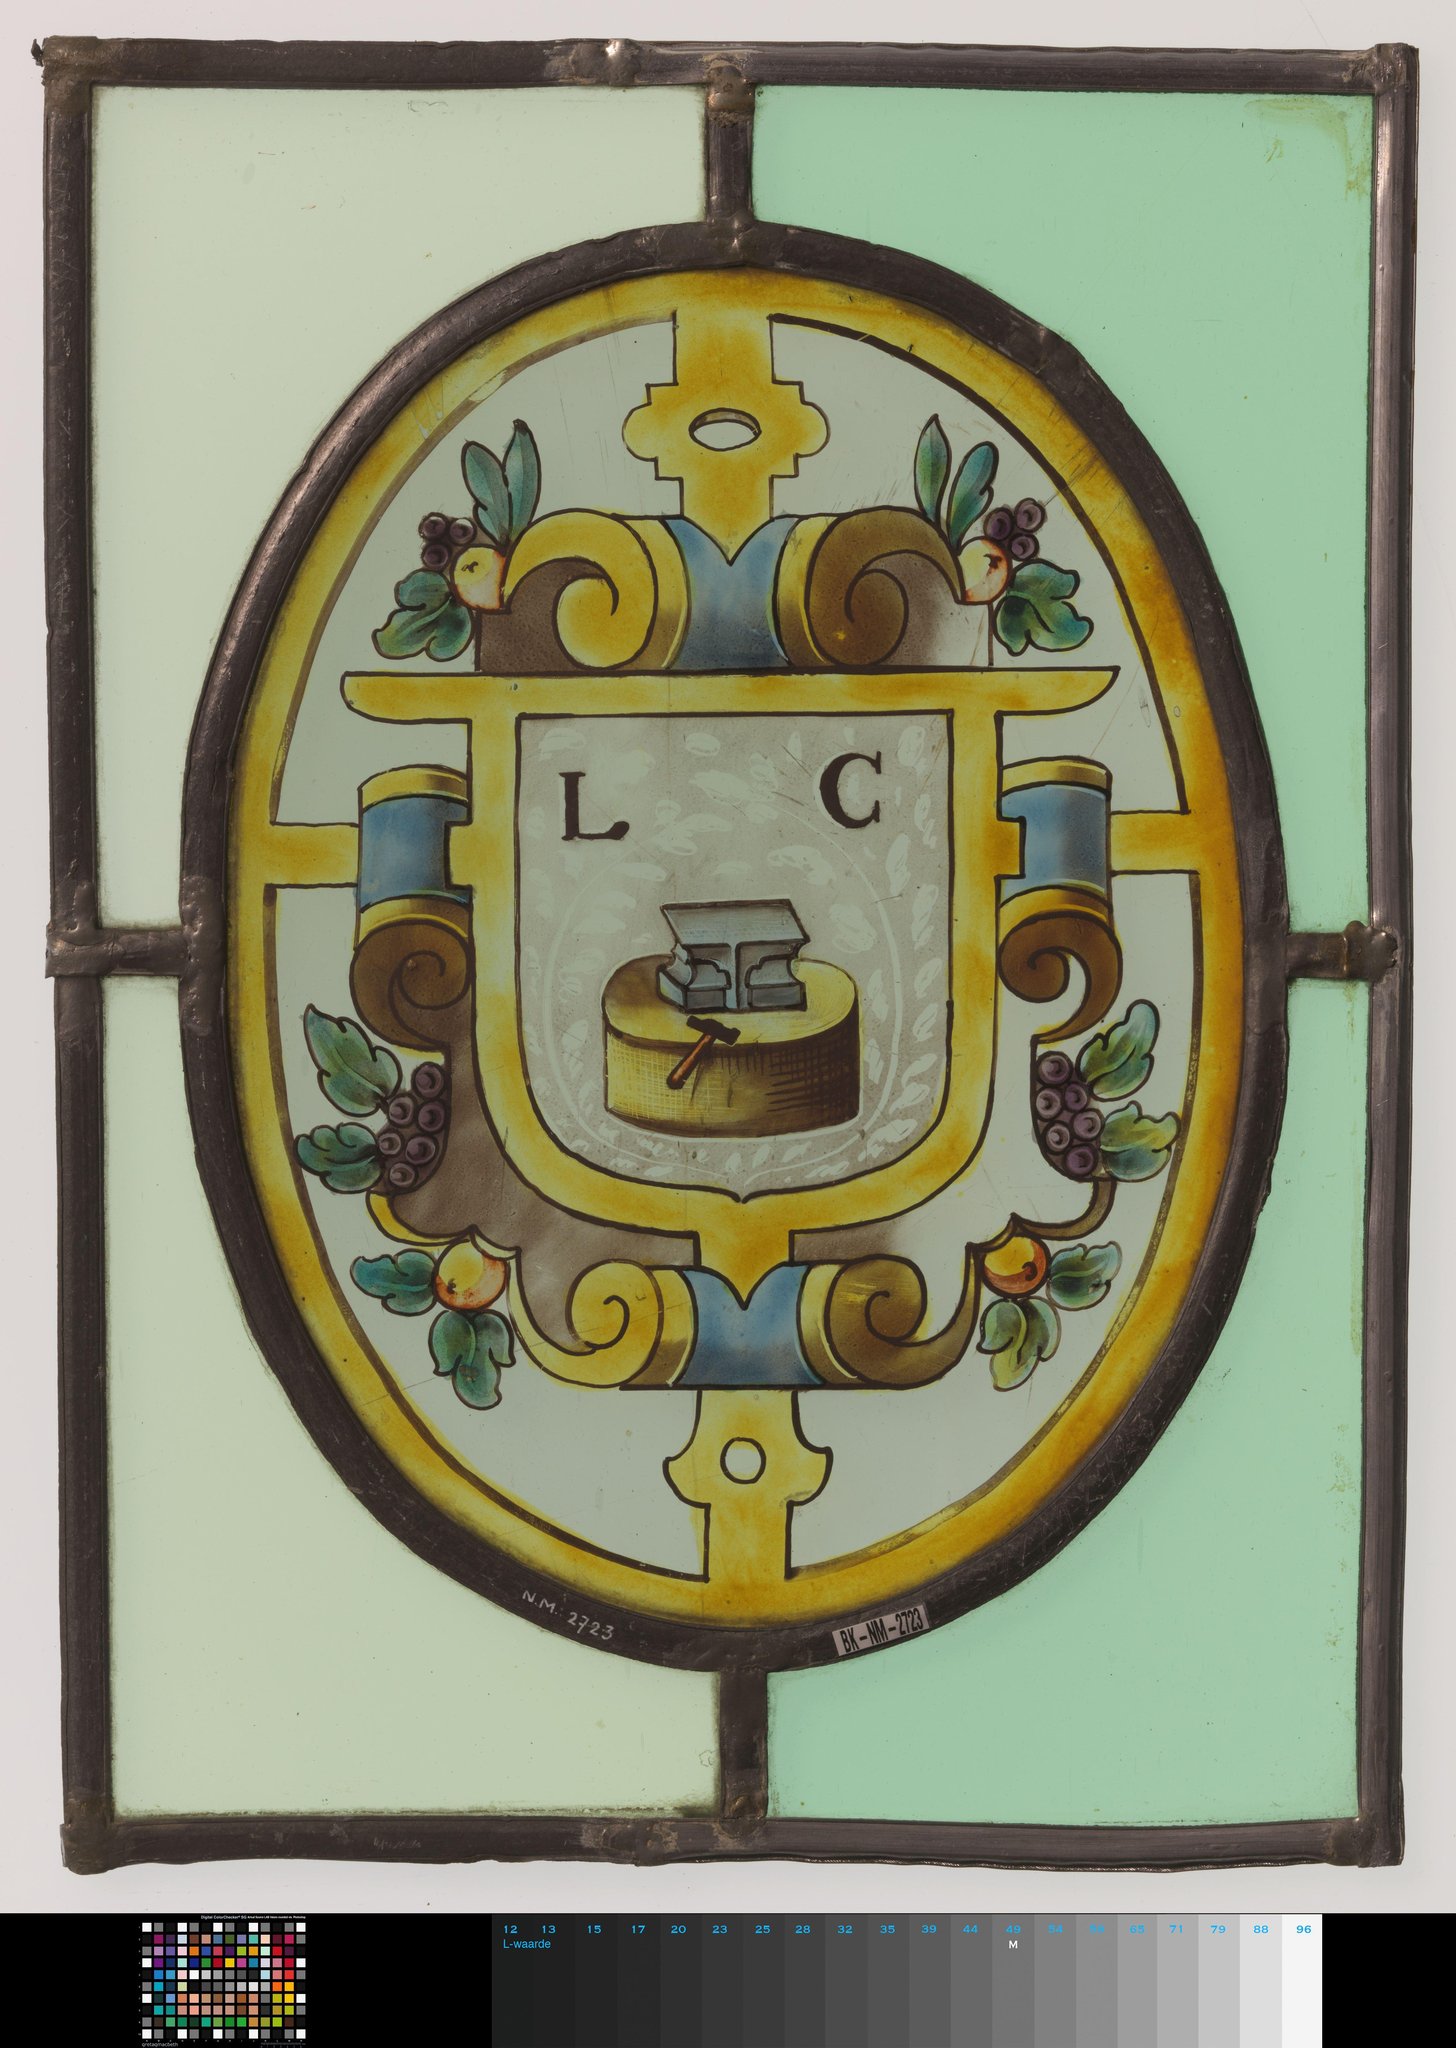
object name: wapenruit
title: Ruit waarin de letters L en C en een aambeeld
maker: Anonymous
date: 1700-1800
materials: glass, lead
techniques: leading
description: Ovale ruit met wapenschild, waarin de letters L en C en een aambeeld met hamer.